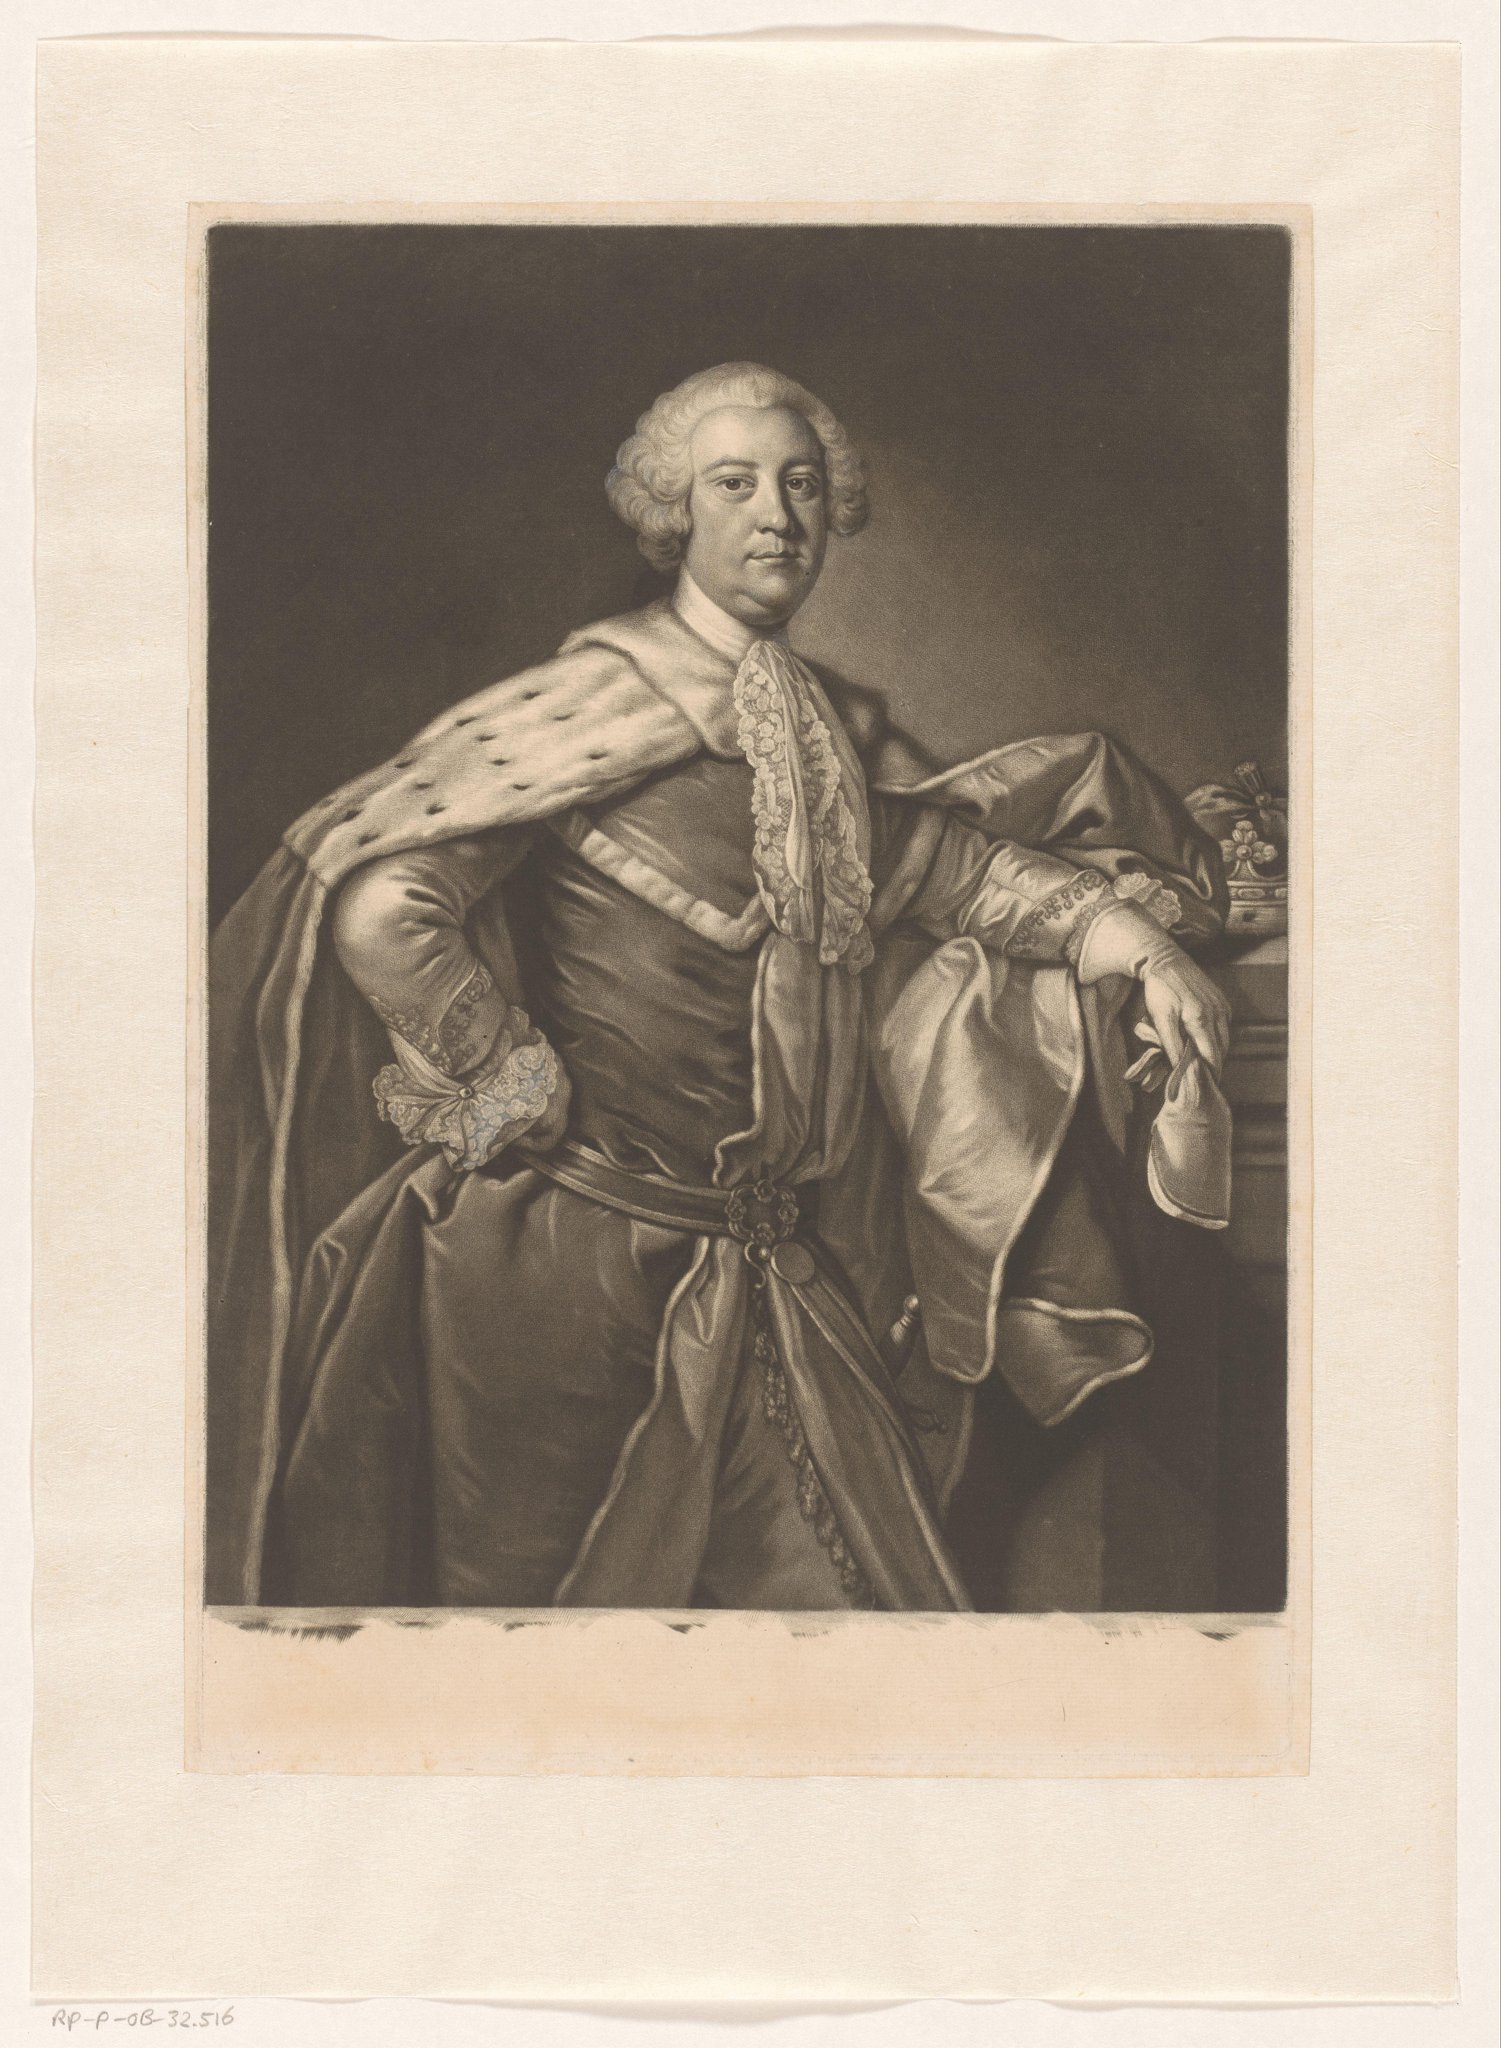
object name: print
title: Portret van Robert Ker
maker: james mcardell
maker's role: print maker, publisher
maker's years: 1728-1765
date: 1755-1765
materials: paint, paper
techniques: brush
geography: london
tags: historical persons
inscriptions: collector's mark: Lugt 240